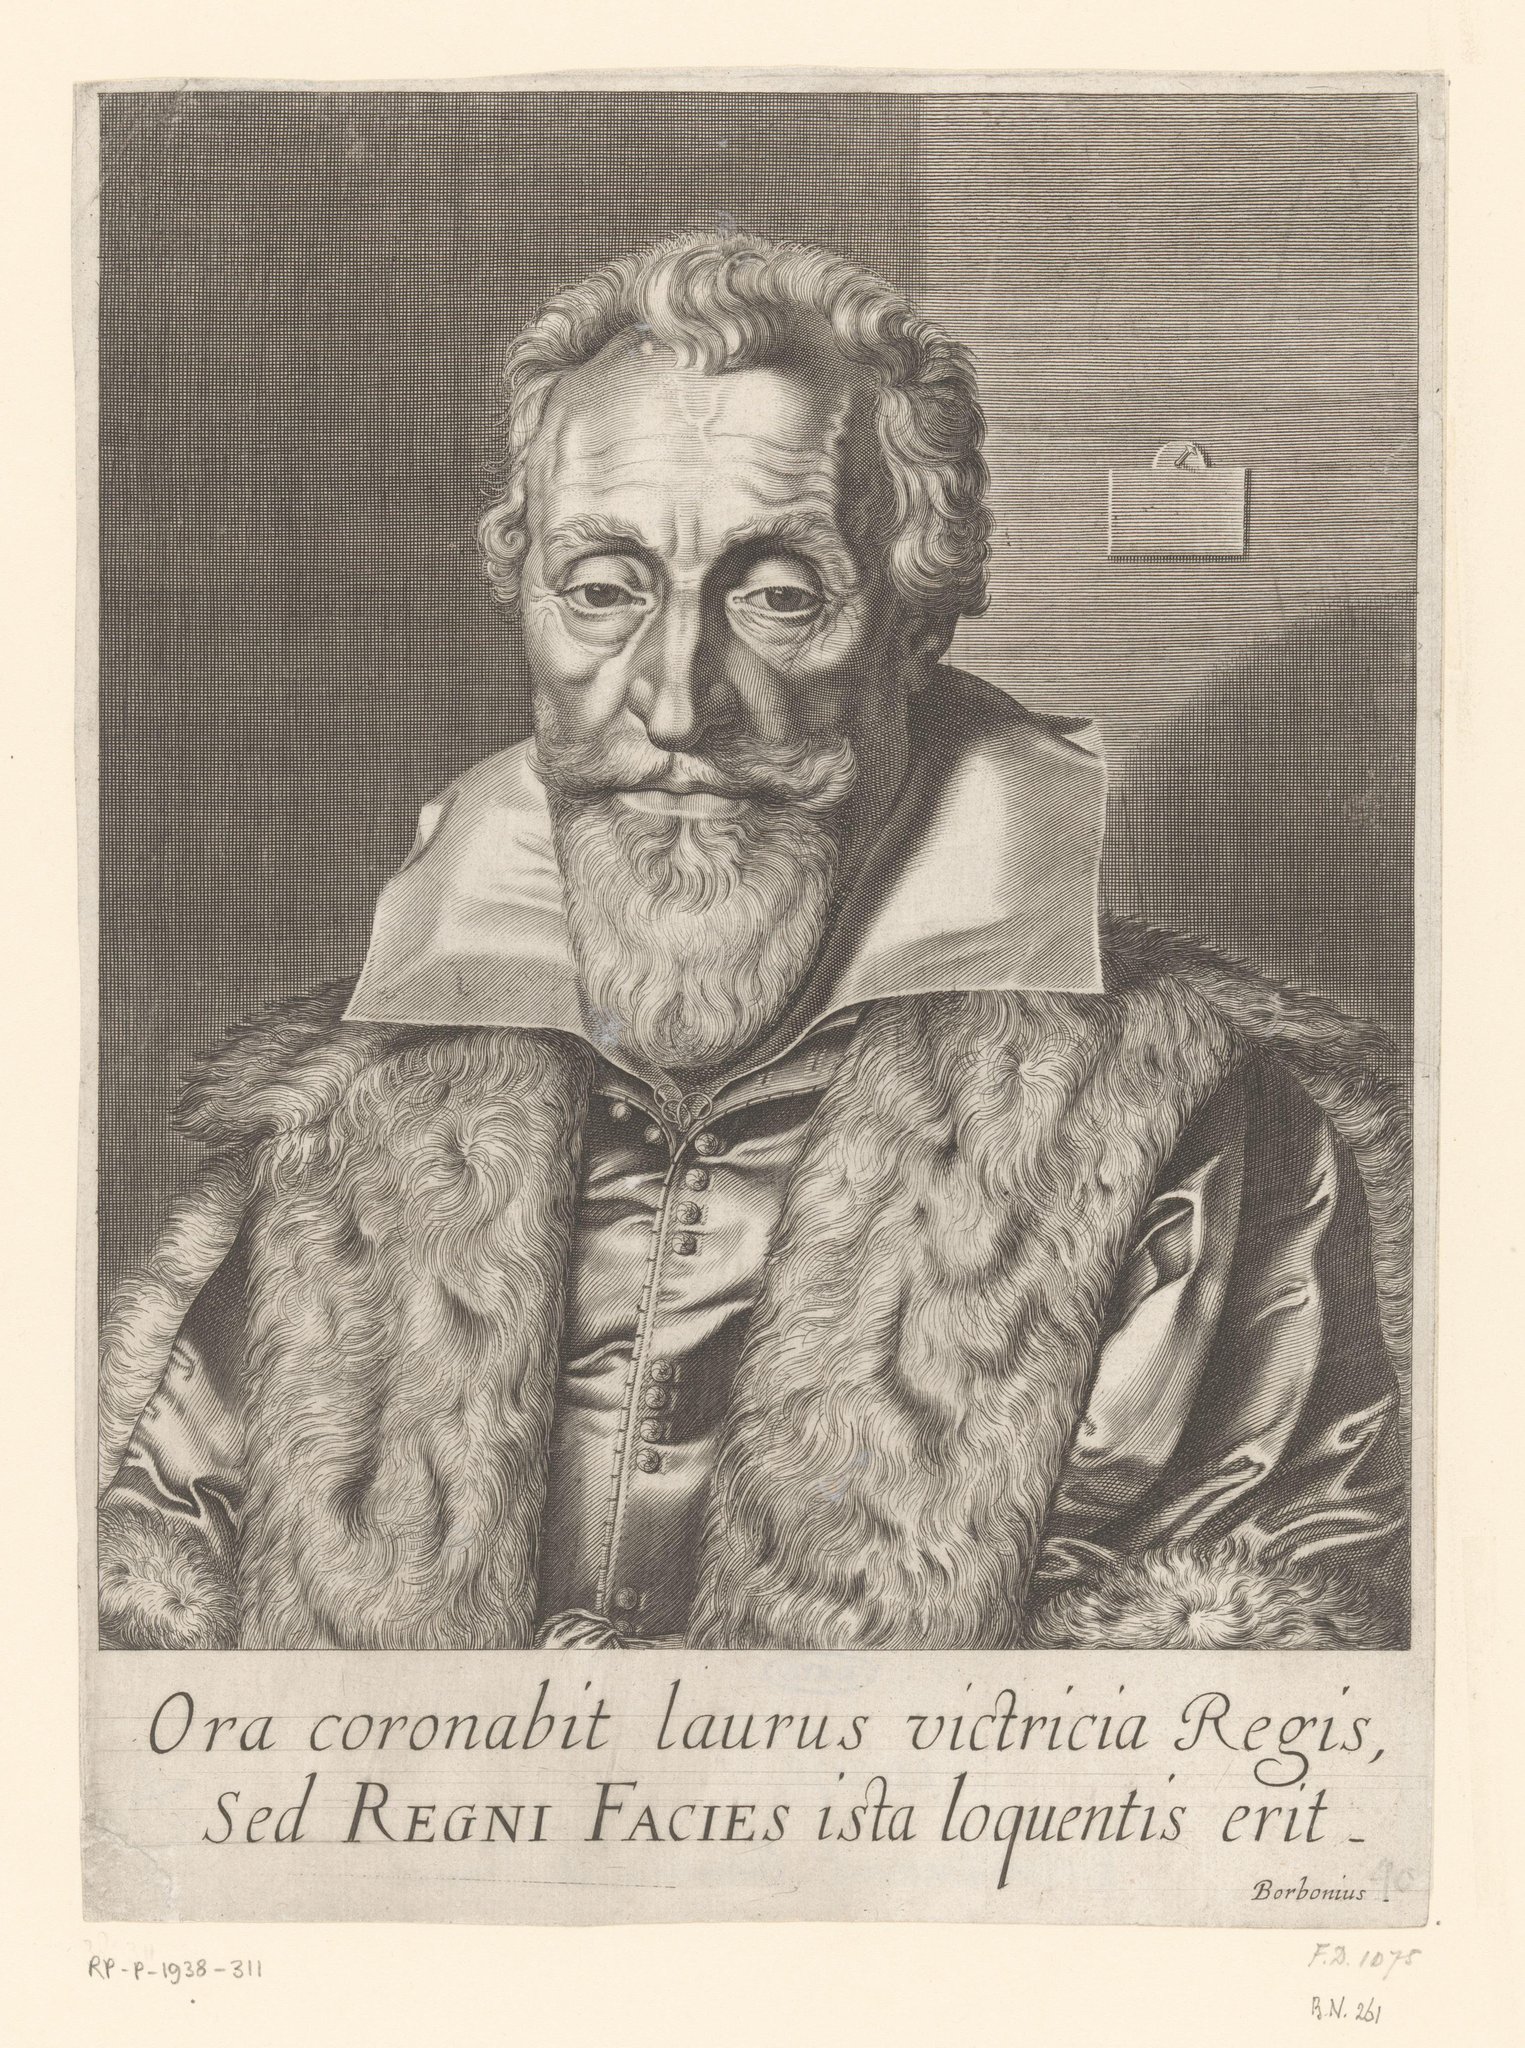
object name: print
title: Portret van Nicolas Brulart de Sillery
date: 1600-1667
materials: paper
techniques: engraving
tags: historical persons, diplomacy, diplomat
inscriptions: collector's mark: Lugt 2228